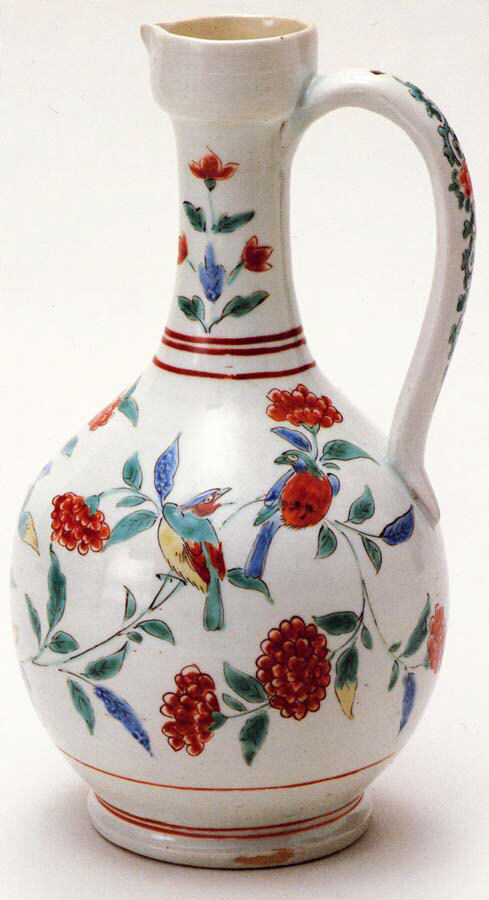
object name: ewer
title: Ewer with Strap Handle and Floral Decoration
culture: japanese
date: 1680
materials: enamel, porcelain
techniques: overglaze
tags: birds